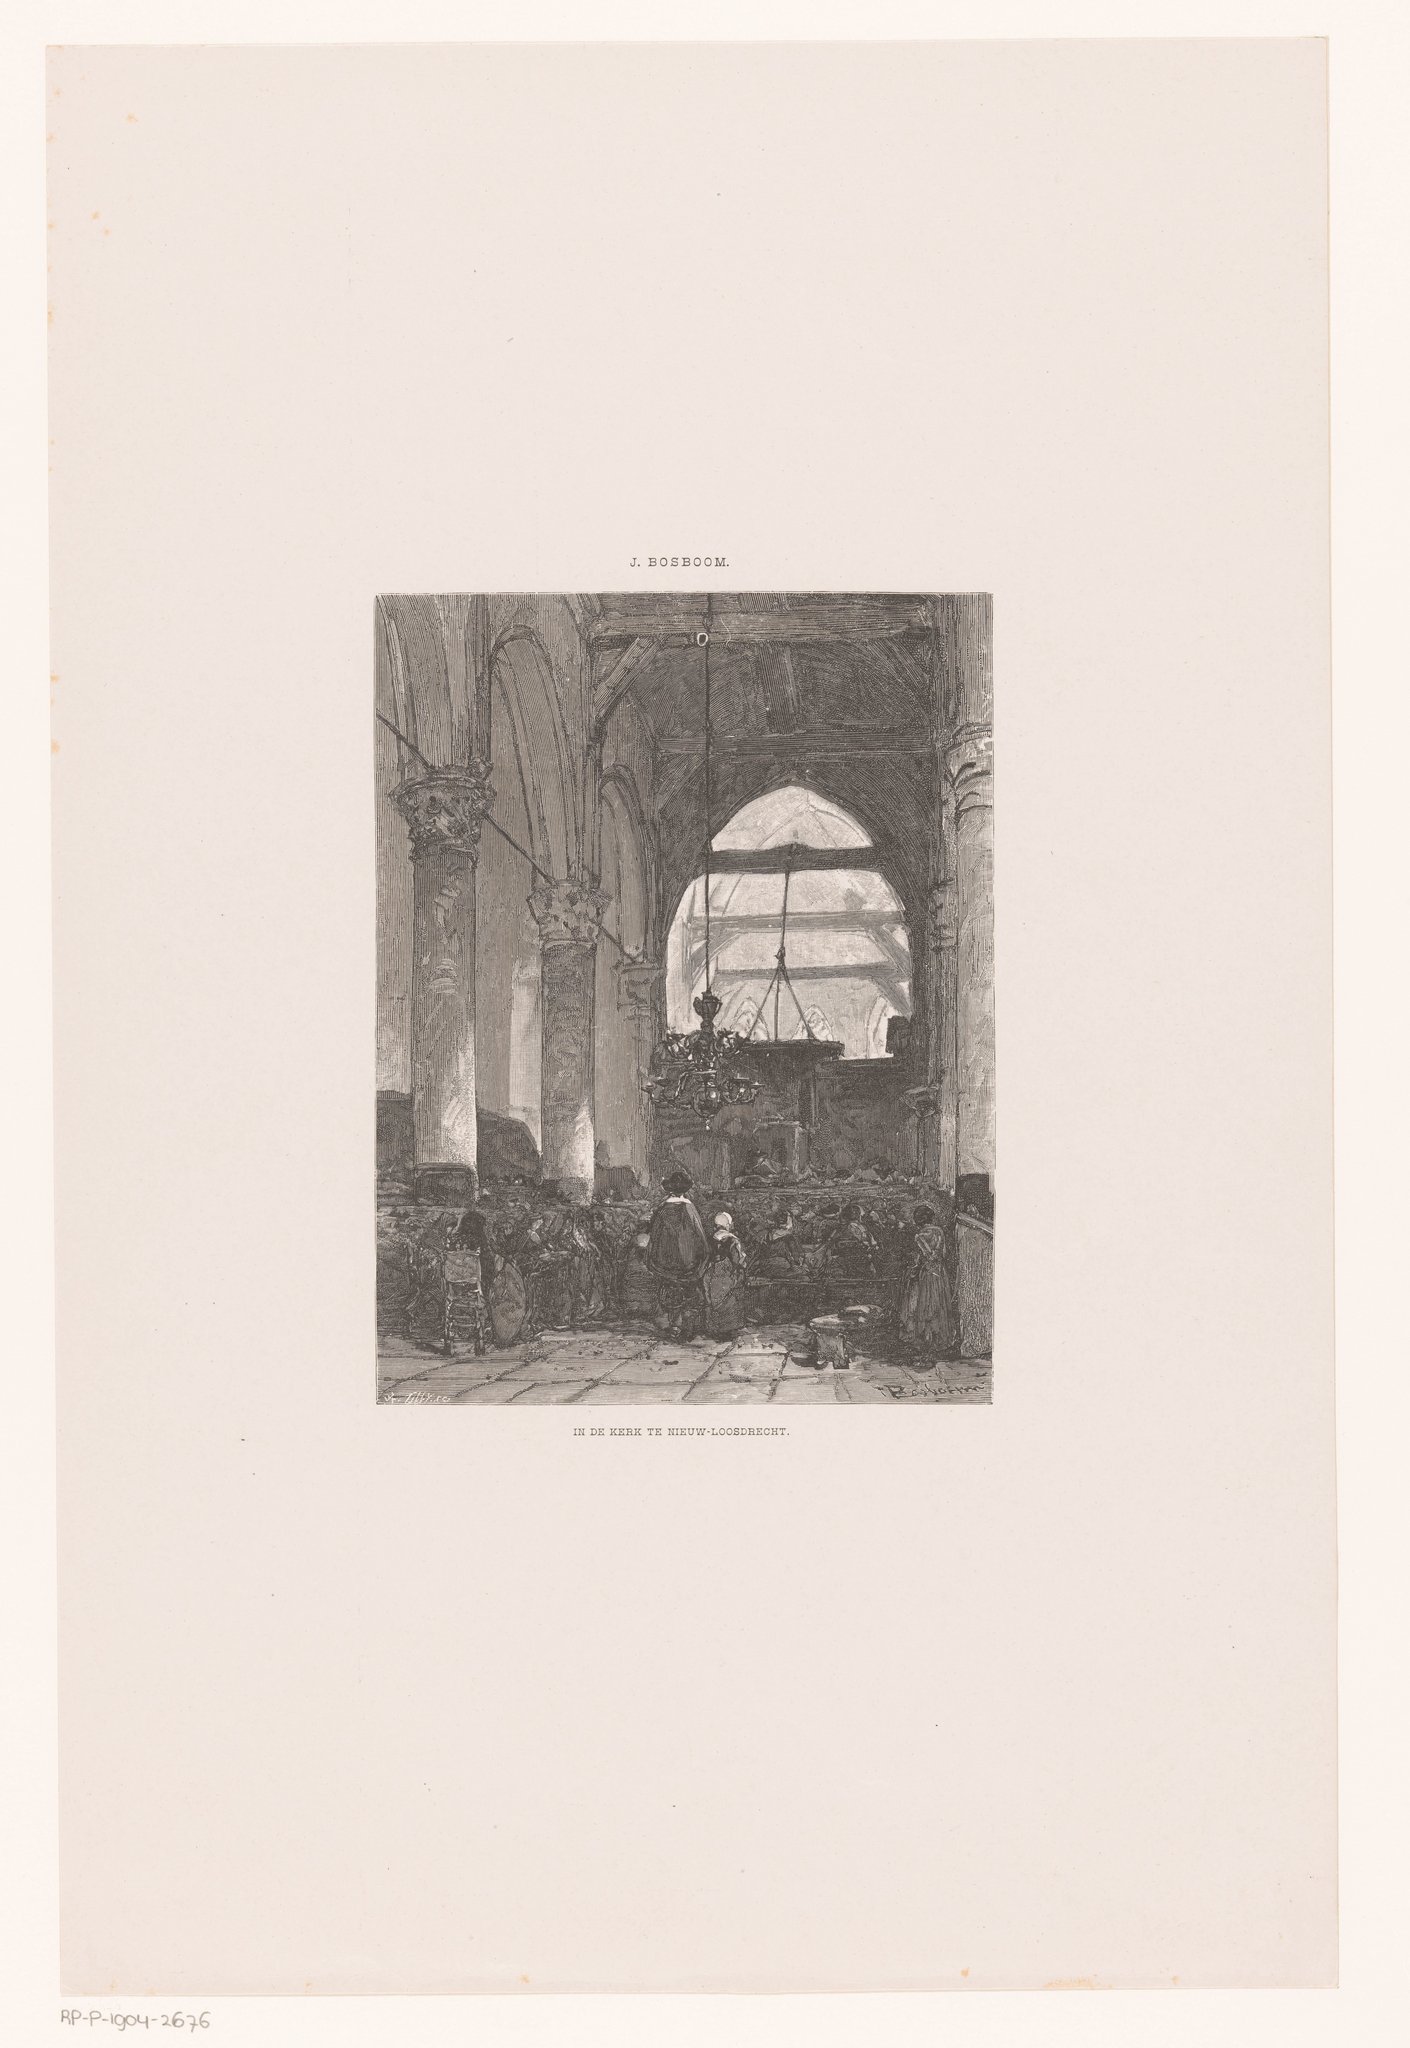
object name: print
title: Interieur van de Sijpekerk in Nieuw-Loosdrecht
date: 1863-1898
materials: paper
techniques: engraving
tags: the place of worship and its equipment ~ christian churches, nieuw-loosdrecht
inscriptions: collector's mark: Lugt 2228